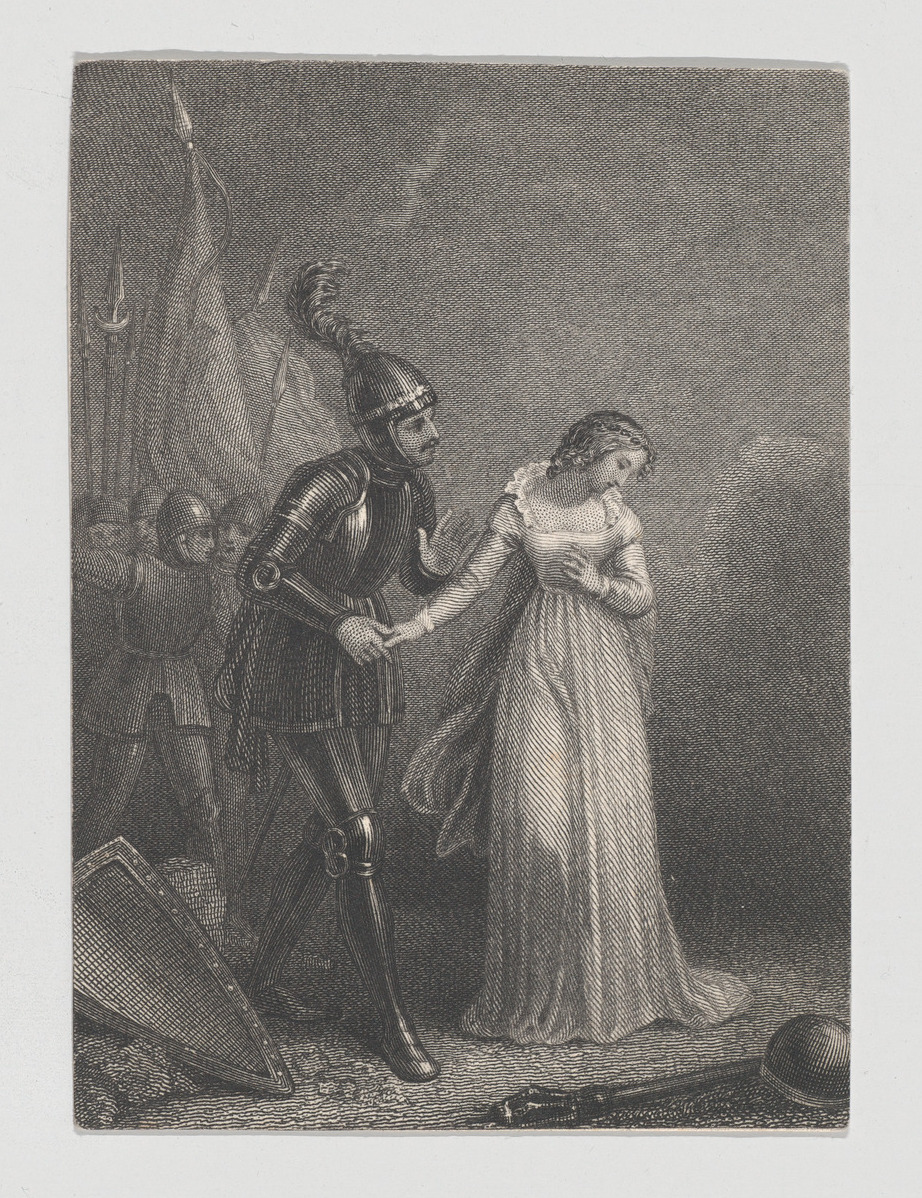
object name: print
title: Suffolk and Margaret (Shakespeare, King Henry VI, Part I, Act 5, Scene 3)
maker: charles heath, the elder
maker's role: engraver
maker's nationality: british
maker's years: 1785-1848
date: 1825-1840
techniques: engraving, etching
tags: shakespeare,men,women